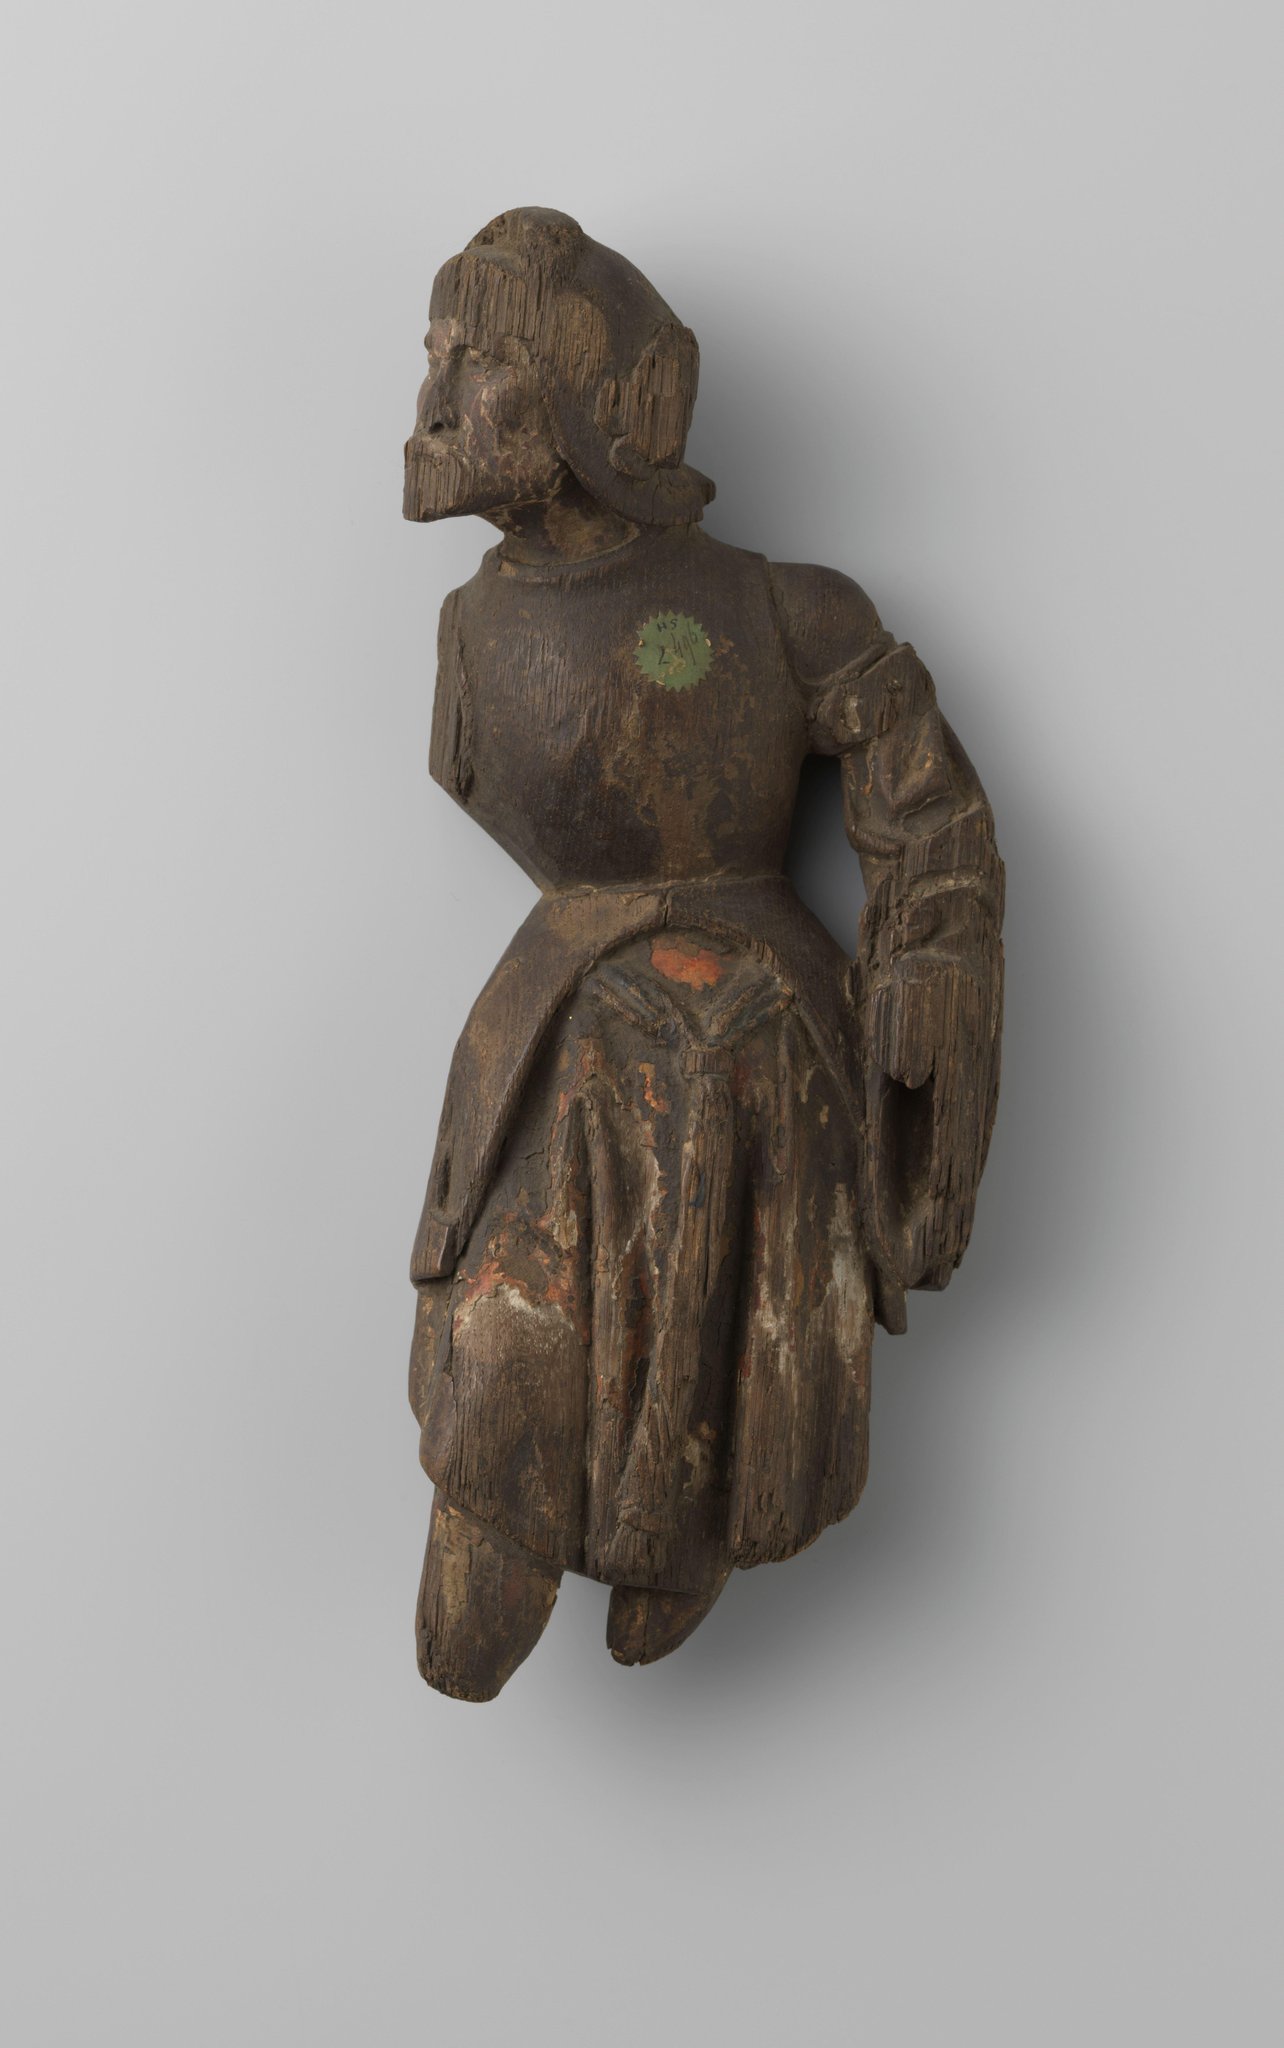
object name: sculpture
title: Beeldhouwwerk van hout, figuur uit een groep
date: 1400-1950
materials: wood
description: Houten beeldhouwwerk. Figuur uit een groep.